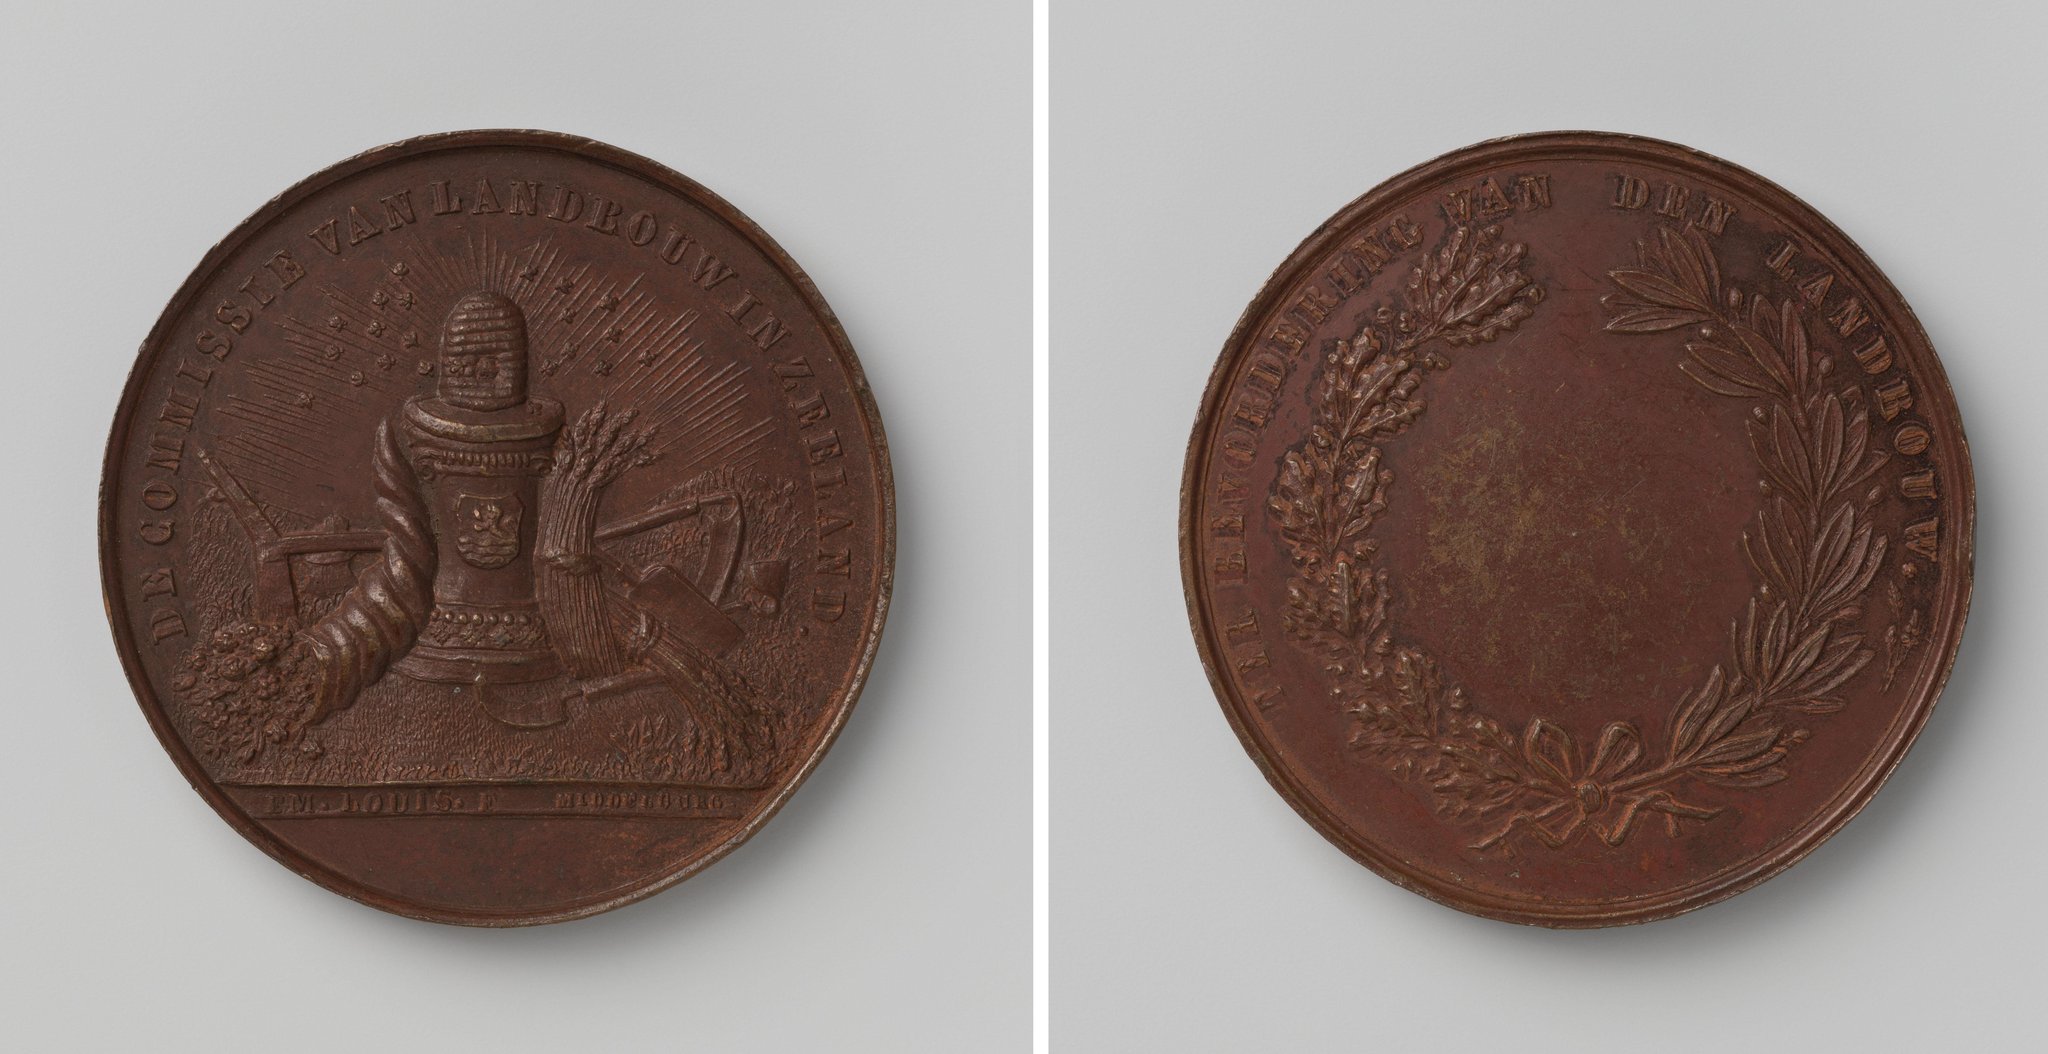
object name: medal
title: Commissie van Landbouw in Zeeland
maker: e.m. louis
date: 1848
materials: bronze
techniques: striking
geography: netherlands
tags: zeeland